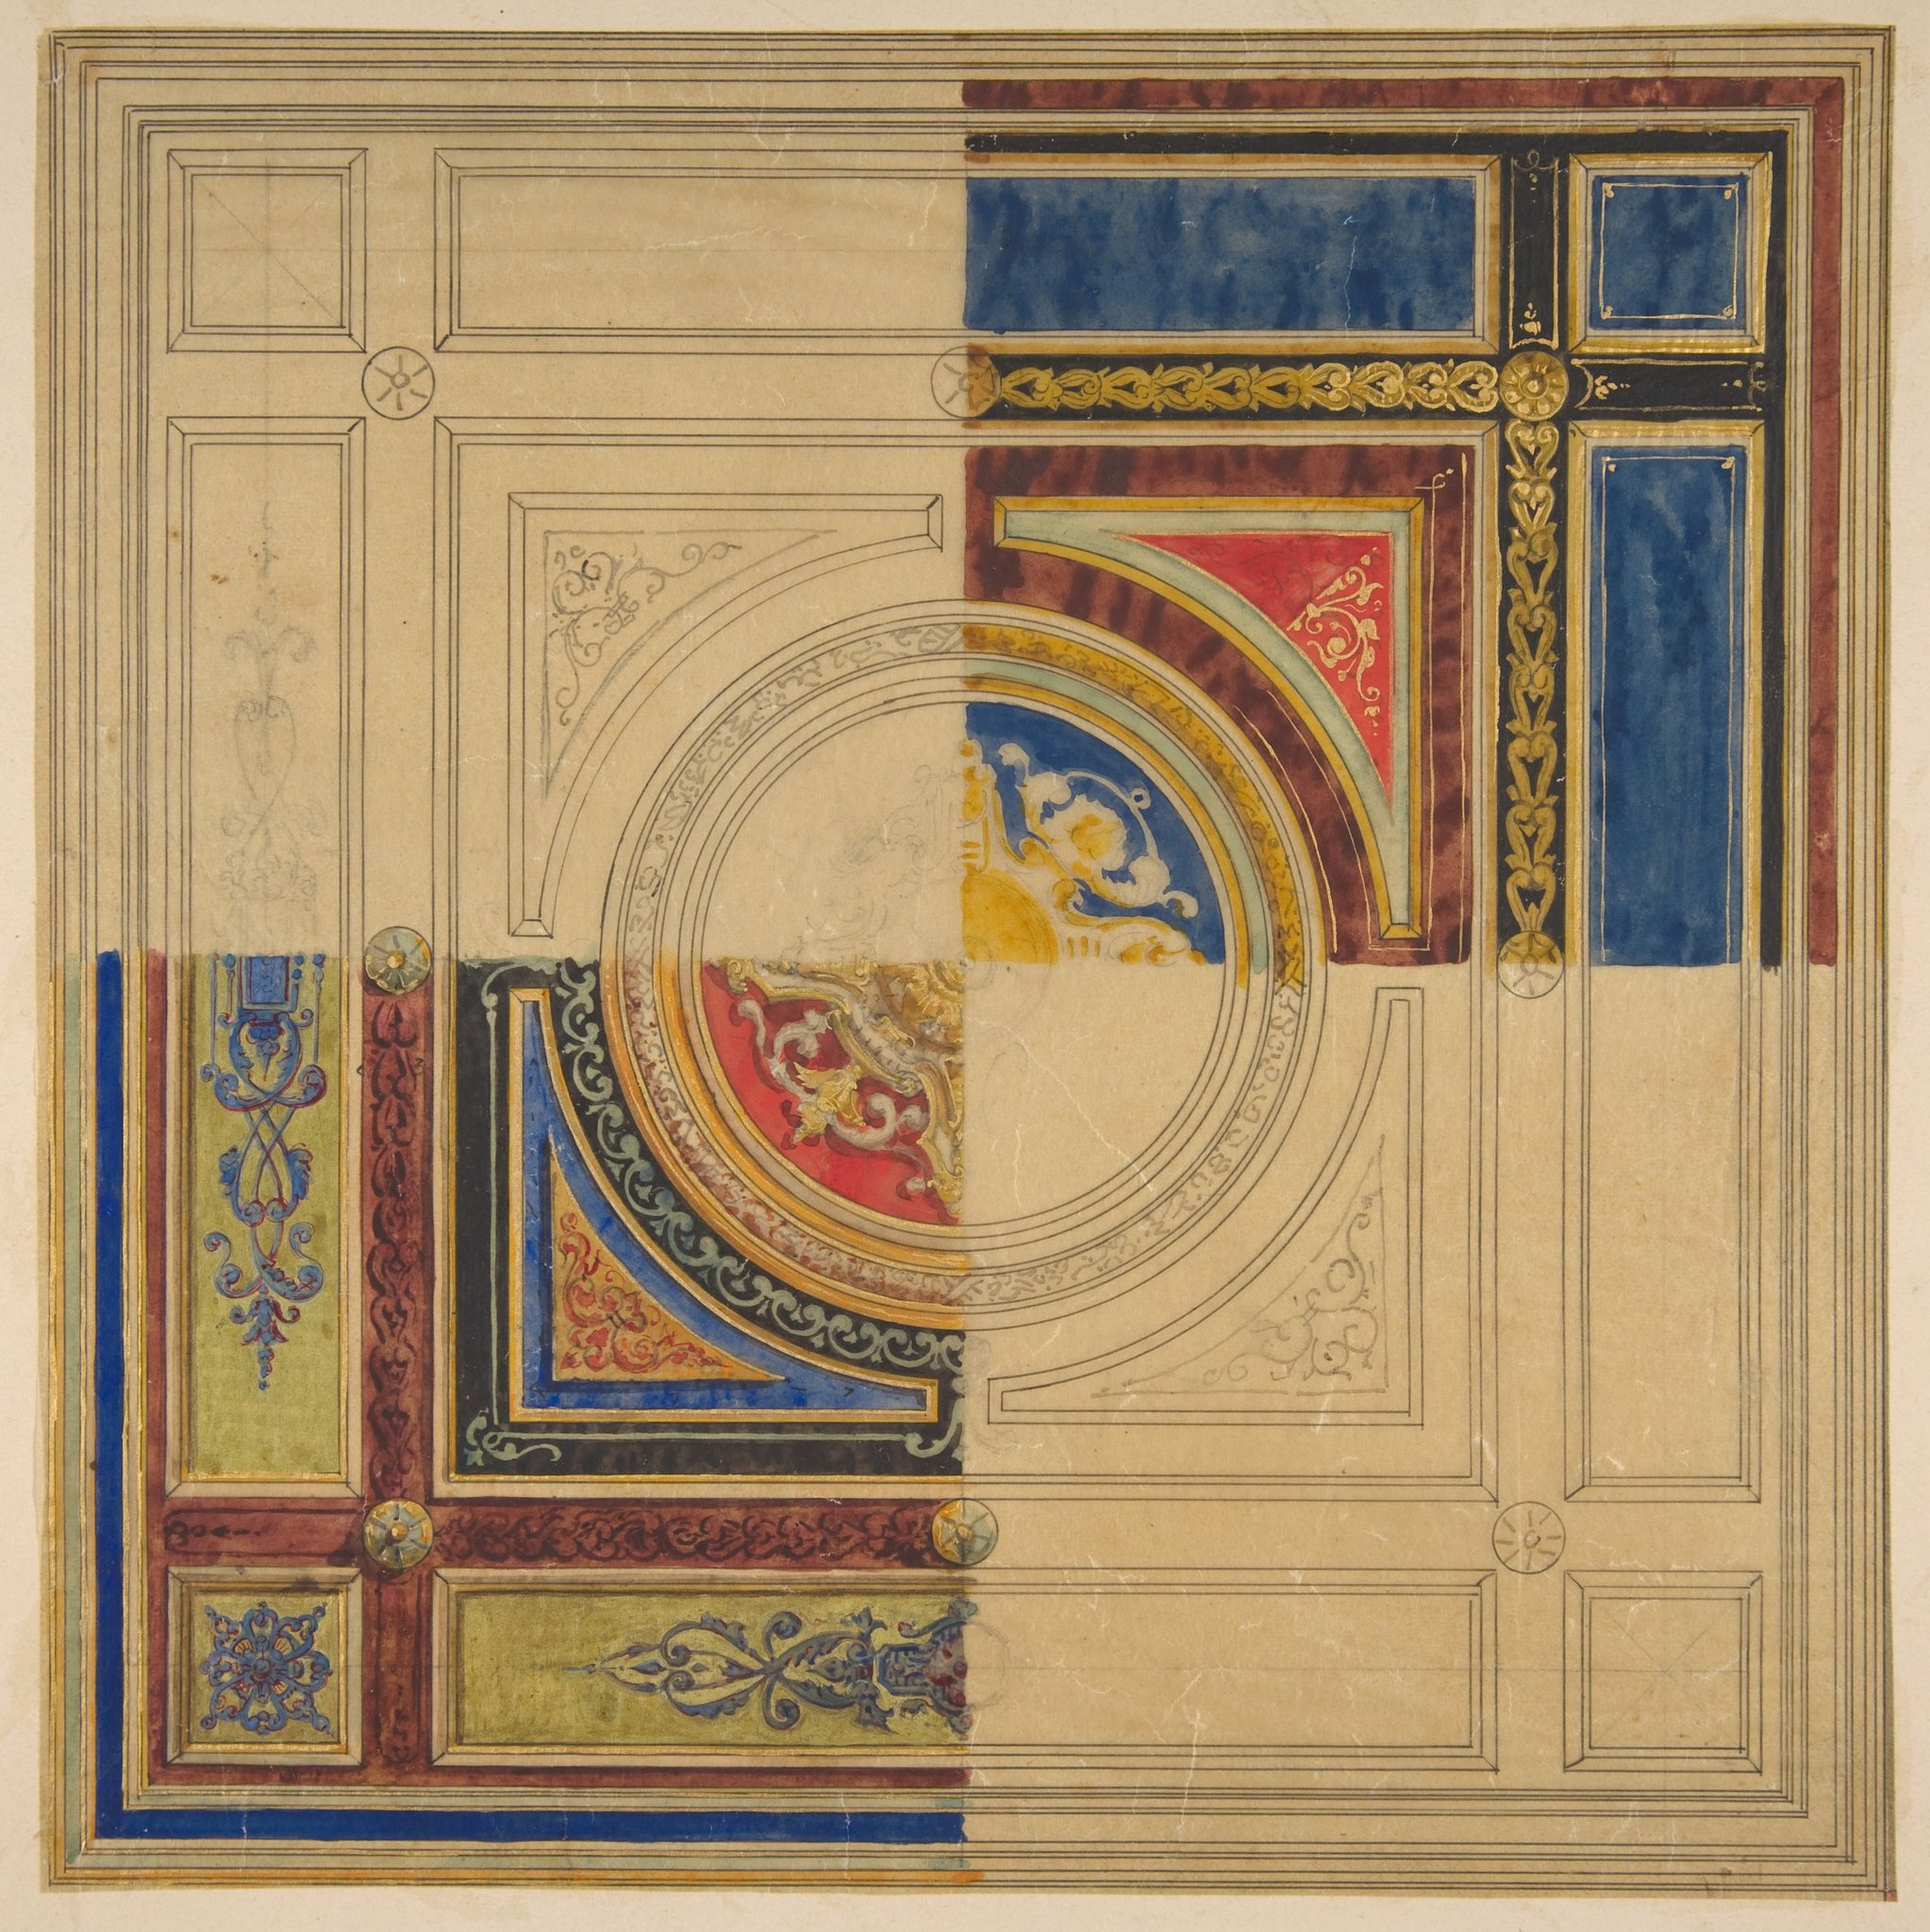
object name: drawing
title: Design for a paneled ceiling with alternative decorations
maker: jules-edmond-charles lachaise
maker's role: artist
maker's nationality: french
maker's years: 1897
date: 1801-1900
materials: gold paint, ink, paper, watercolor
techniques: pen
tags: architecture,ceilings